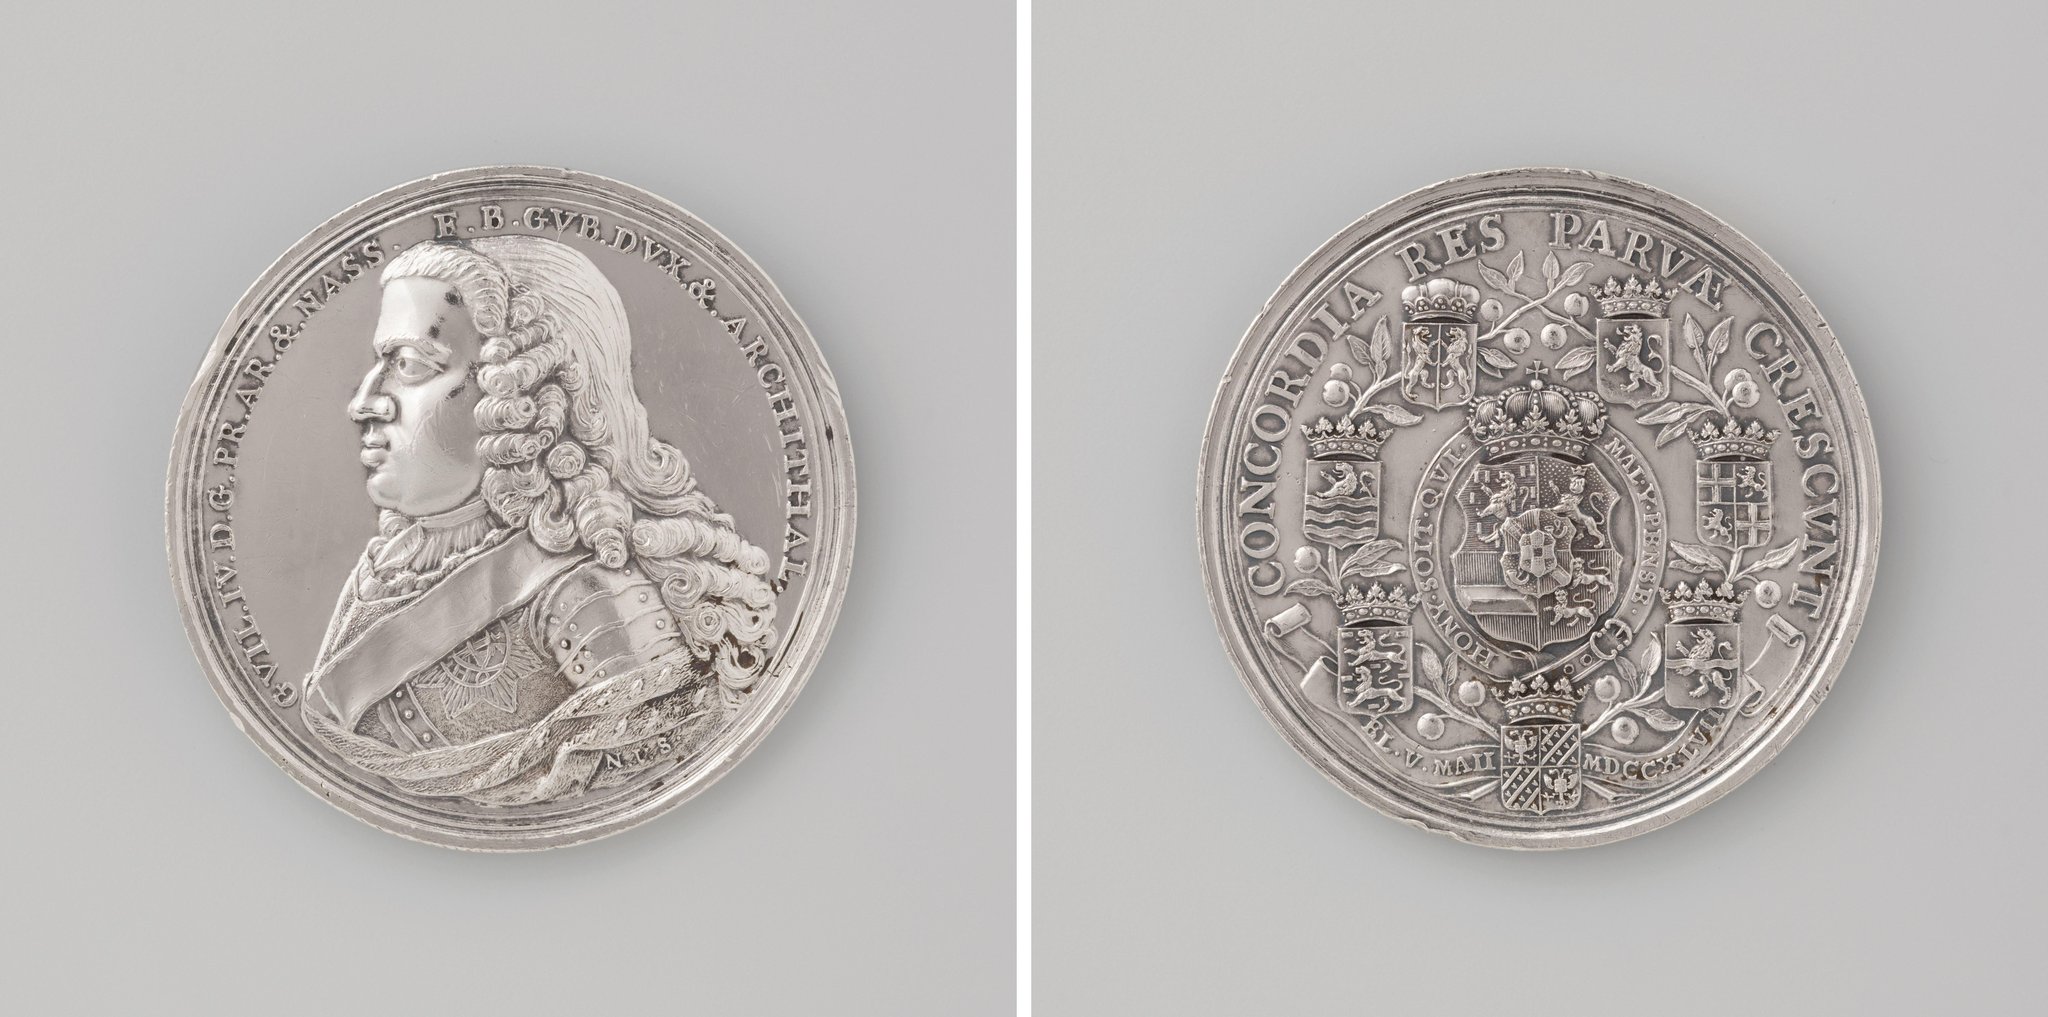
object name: history medal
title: Verheffing van de prins van Oranje tot stadhouder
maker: nicolaas van swinderen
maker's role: jeweler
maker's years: 1705-1760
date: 1747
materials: silver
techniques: striking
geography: the hague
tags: the hague, willem iv (prins van oranje-nassau)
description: Zilveren penning. Voorzijde: borststuk man binnen omschrift. Keerzijde: gekroond wapenschild, omhangen met orde van kouseband en omgeven door zeven gekroonde, aan oranjetakken vastgehechte wapenschilden boven wimpel met opschrift binnen omschrift